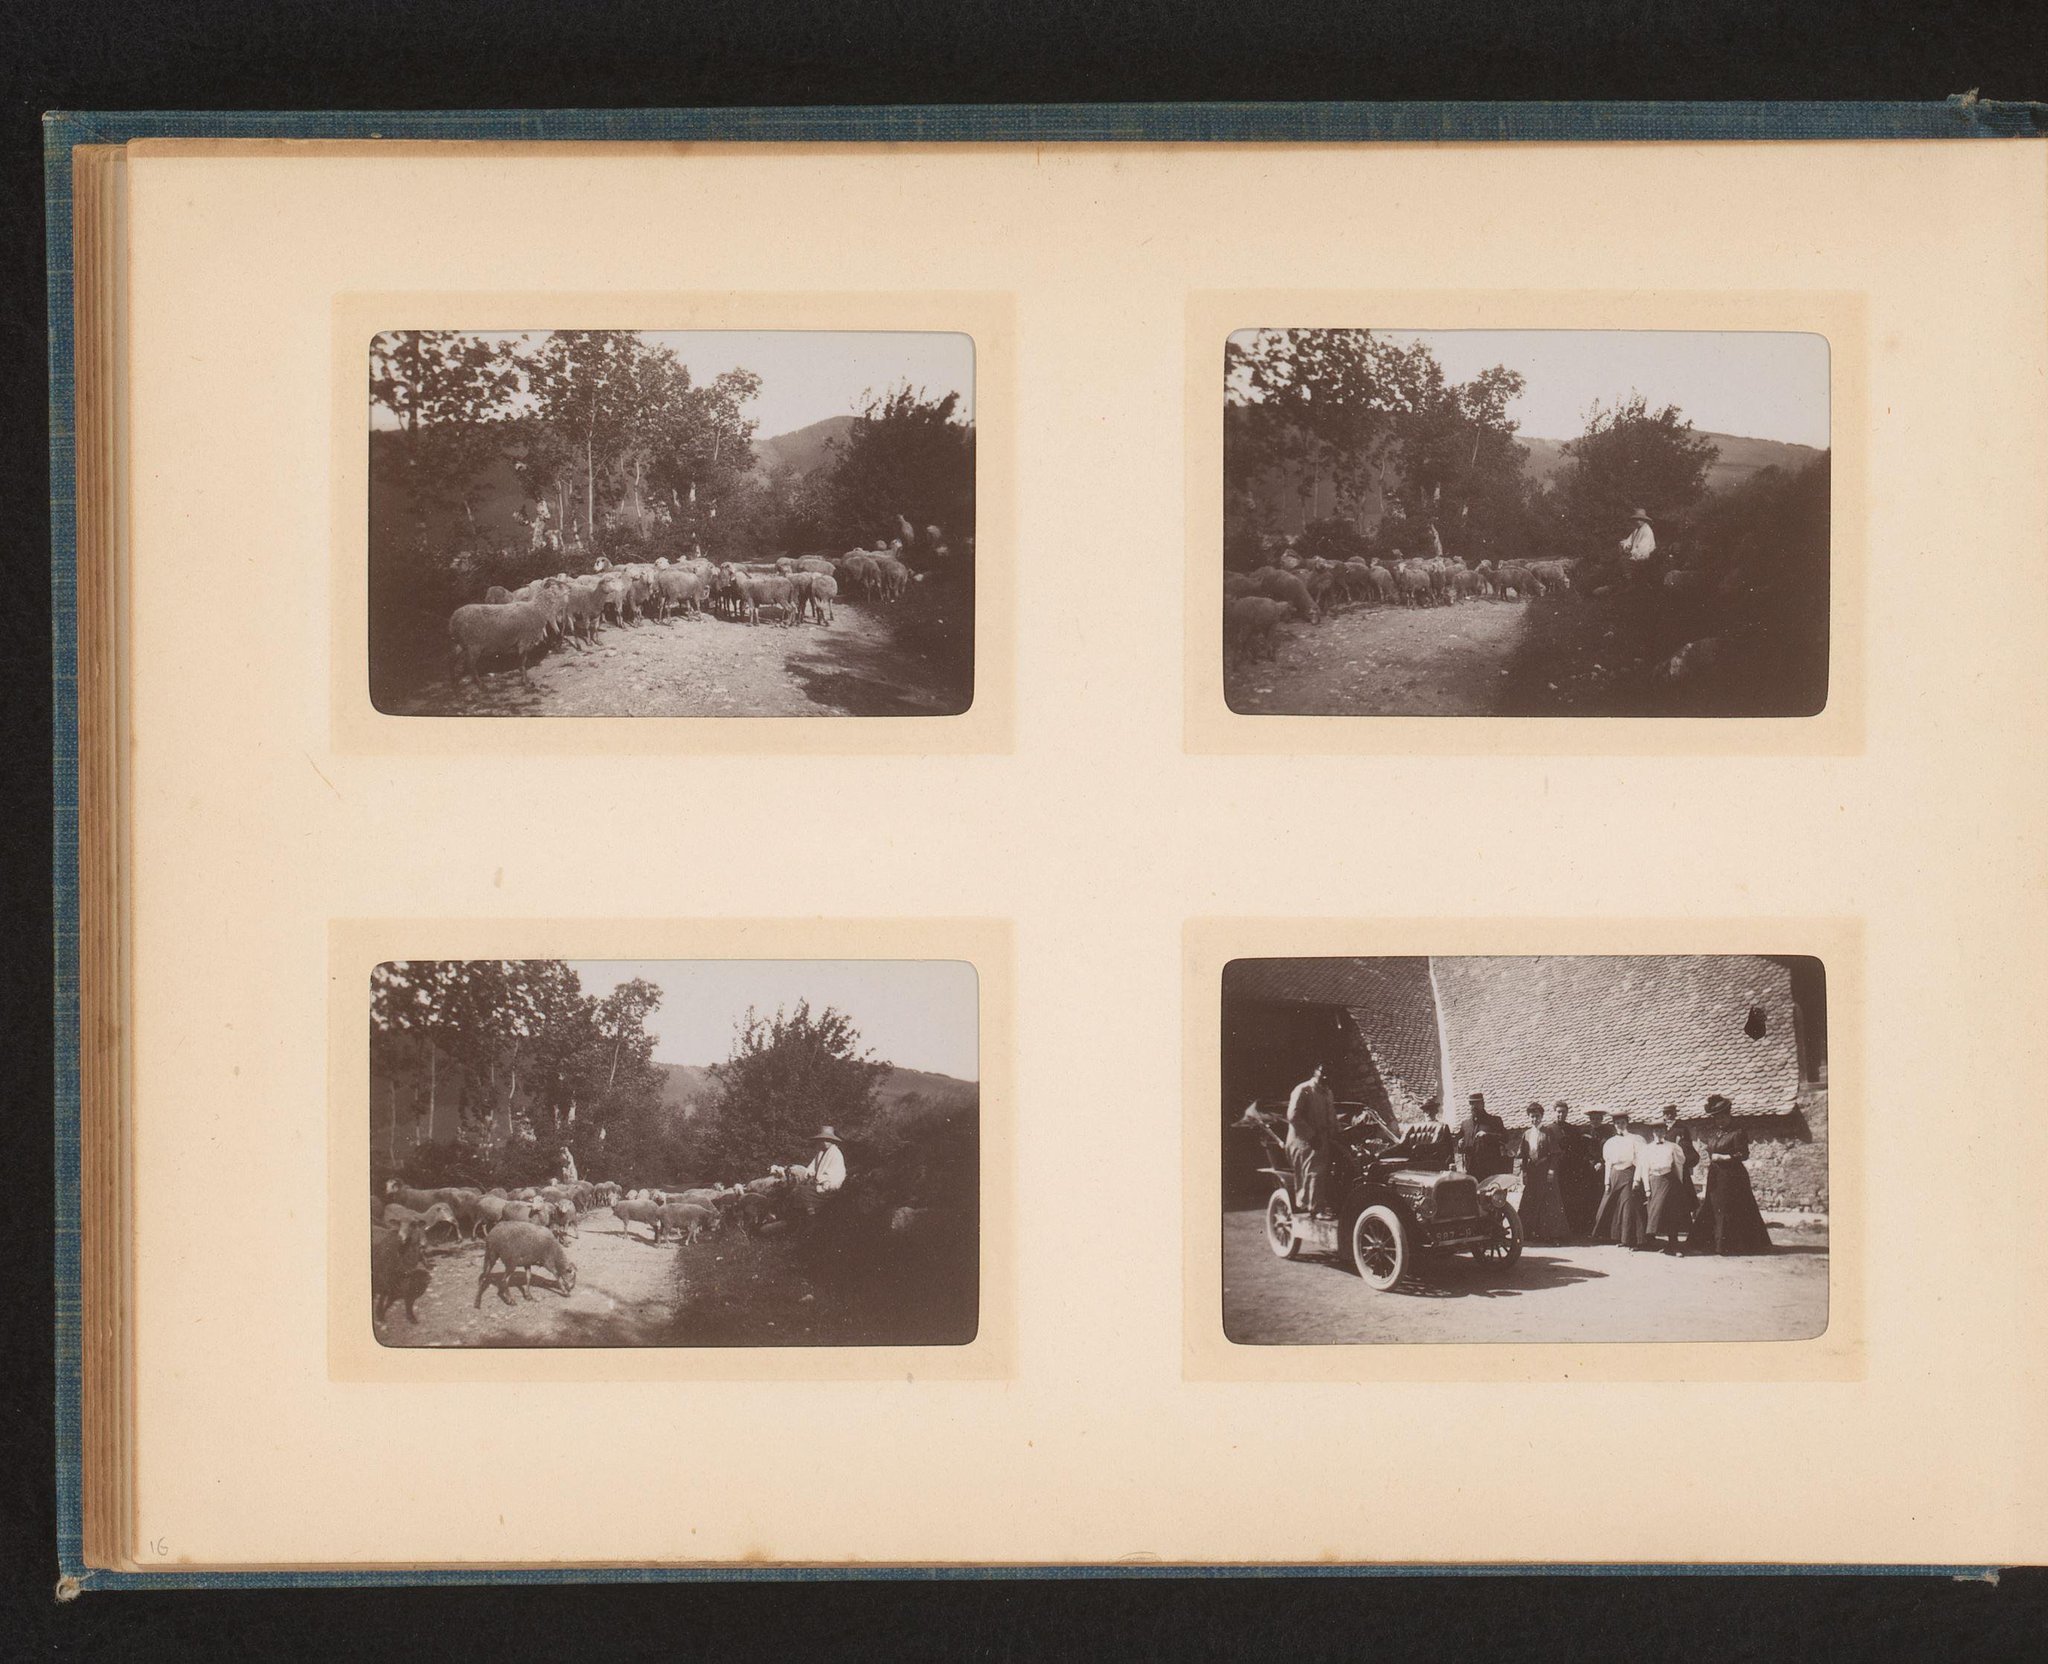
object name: album leaf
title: Drie opnamen van schapen op een weg en Groepsportret van verschillende personen bij een boerderij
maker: Anonymous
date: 1900-1915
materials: paper, photographic support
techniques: gelatin silver print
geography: france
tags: sheep, travelling; tourism, herd, flock, anonymous historical persons portrayed in a group, in a group-portrait, france